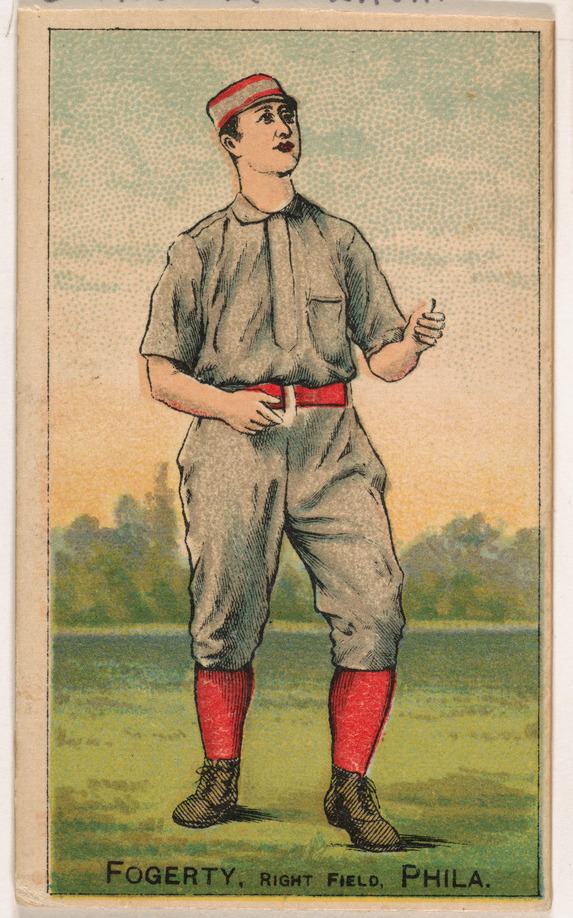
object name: baseball card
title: Fogerty, Right Field, Philadelphia, from the Gold Coin series (N284) for Gold Coin Chewing Tobacco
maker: d. buchner & co., new york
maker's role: publisher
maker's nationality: american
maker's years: 1850-1900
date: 1887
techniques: color lithograph, drawing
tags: men,baseball,athletes